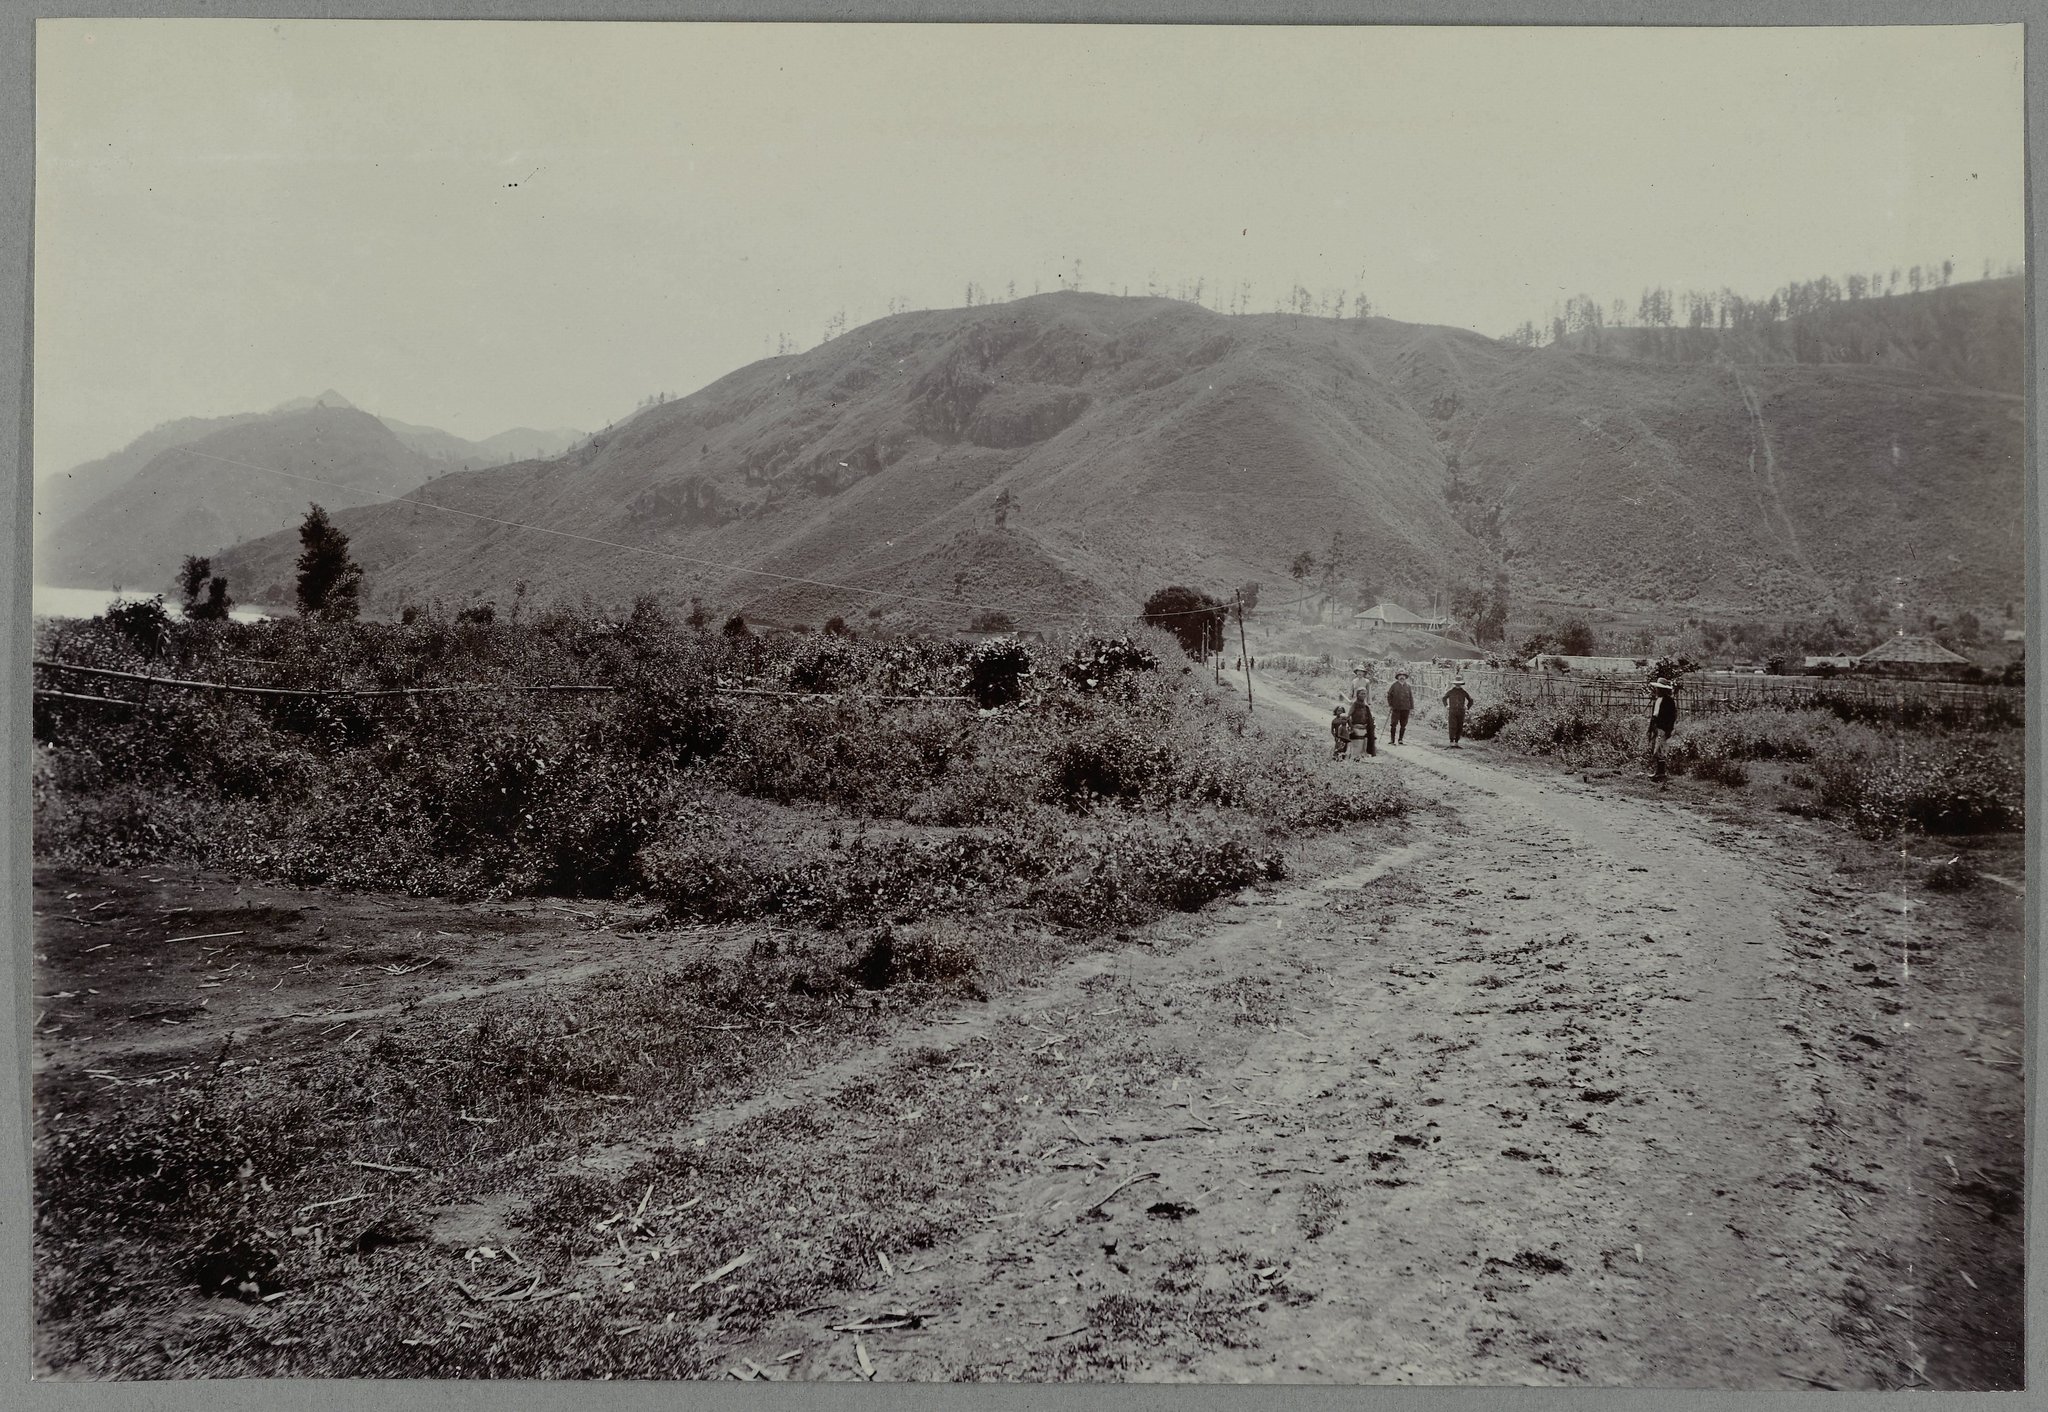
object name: photograph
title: Weg in Takinguen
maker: Anonymous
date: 1903-1913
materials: photographic support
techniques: photography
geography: north sumatra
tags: albertus dominicus laman trip, landscapes in tropical and sub-tropical regions, road, path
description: Na de expedities naar de Gajo- en Alaslanden o.l.v. Van Daalen (eerste tocht in 1901), werd hij in 1903 belast met voorbereiding van permanente vestiging van Nederlands gezag. Aanleg van een weg van de Noordkust naar het binnenland was hierbij van groot belang. Deze zgn. Gajoweg werd aangelegd tussen 1903 en 1914, van Bireuen aan de kust naar Takinguen aan het bergmeer Danau Lauttawar, totale lente 104 km.